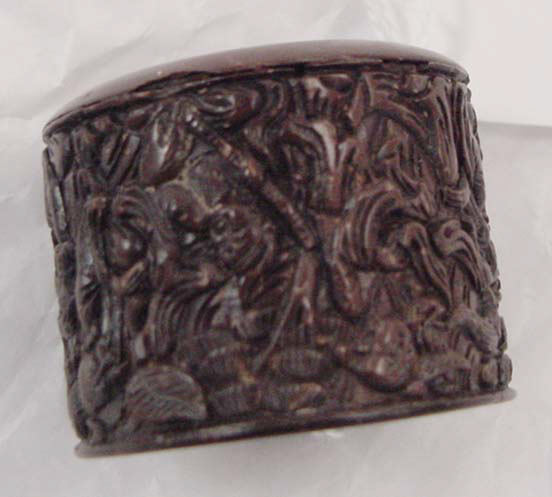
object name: ring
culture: chinese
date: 1801-1900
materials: wood